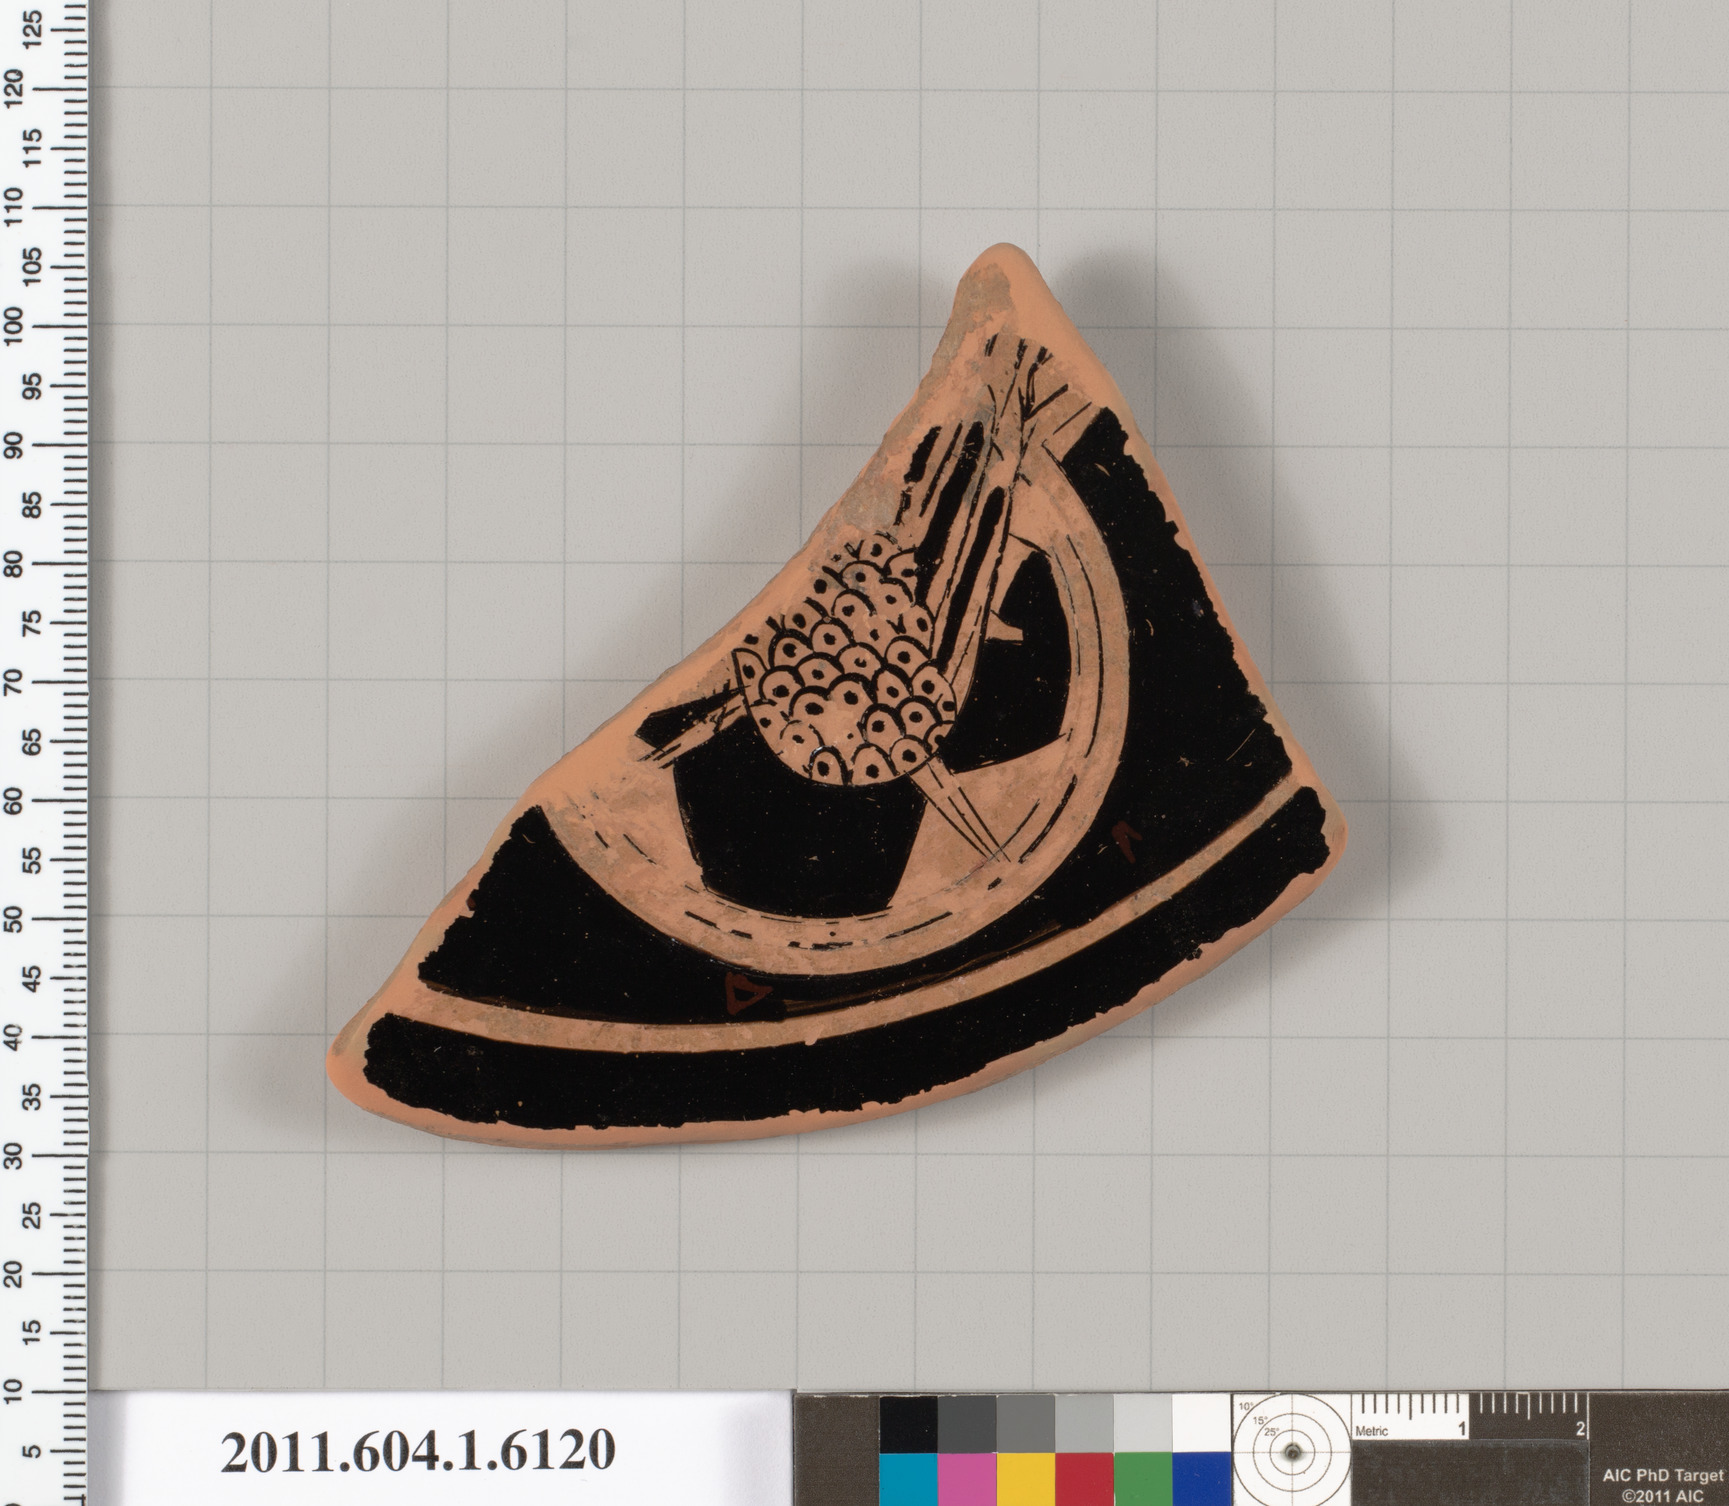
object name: kylix fragment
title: Terracotta fragment of a kylix (drinking cup)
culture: greek, attic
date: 520-500 BCE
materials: terracotta